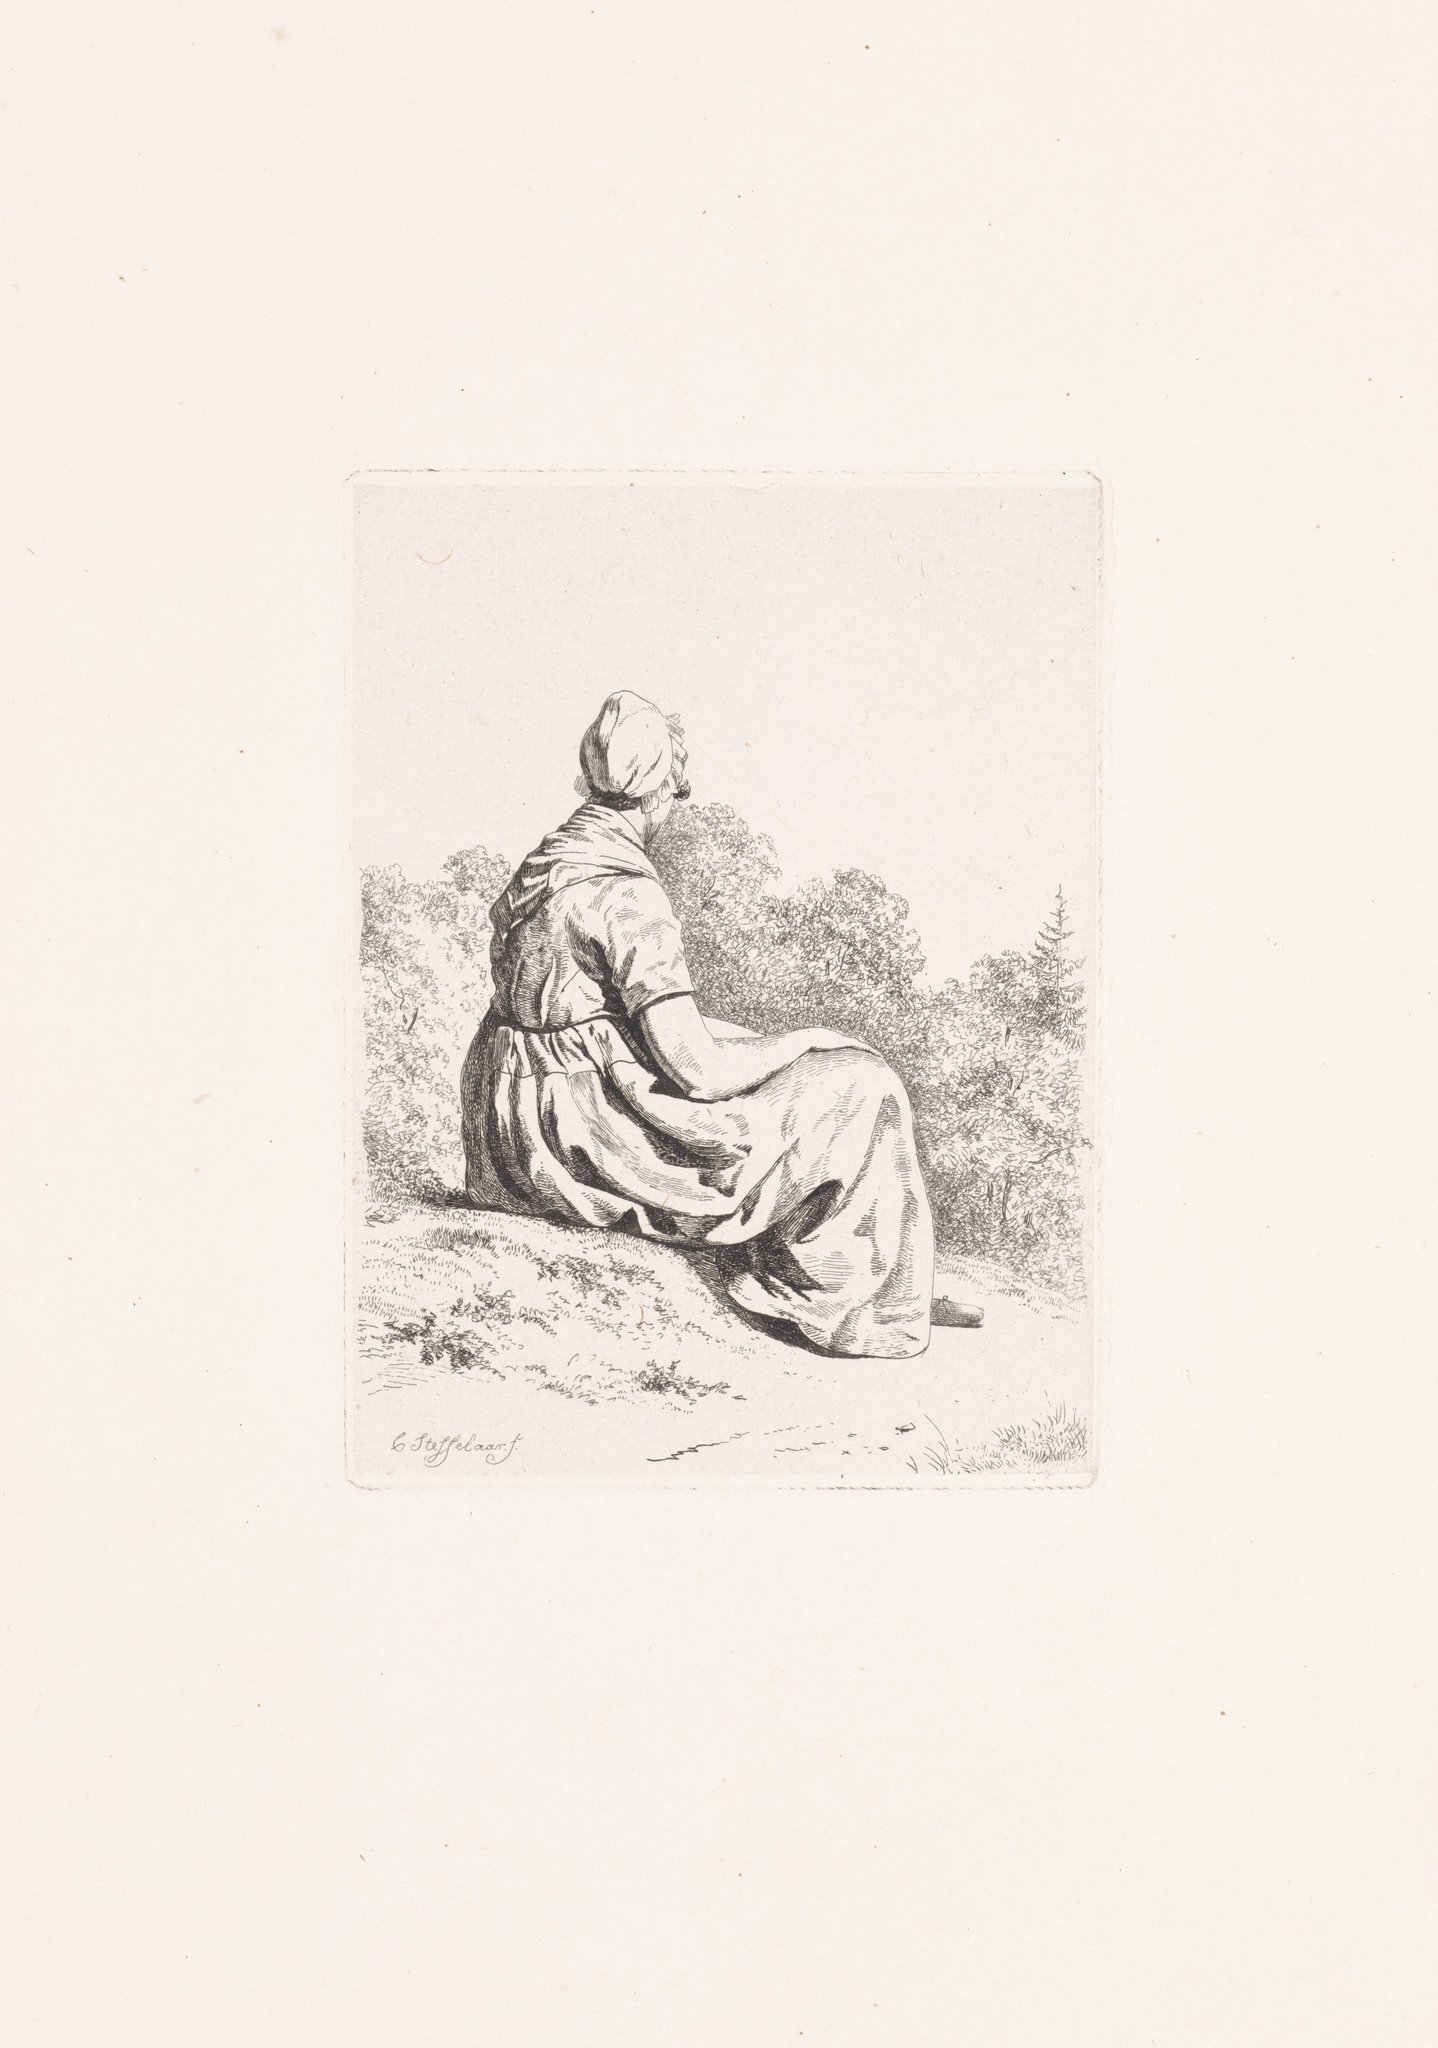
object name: print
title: Vierde suite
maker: cornelis steffelaar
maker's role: draughtsman, painter, print maker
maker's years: 1797-1861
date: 1807-1861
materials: paper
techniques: etching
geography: amsterdam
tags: sitting figure - aa - female human figure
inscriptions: collector's mark: Lugt 2228, collector's mark: Lugt 2760